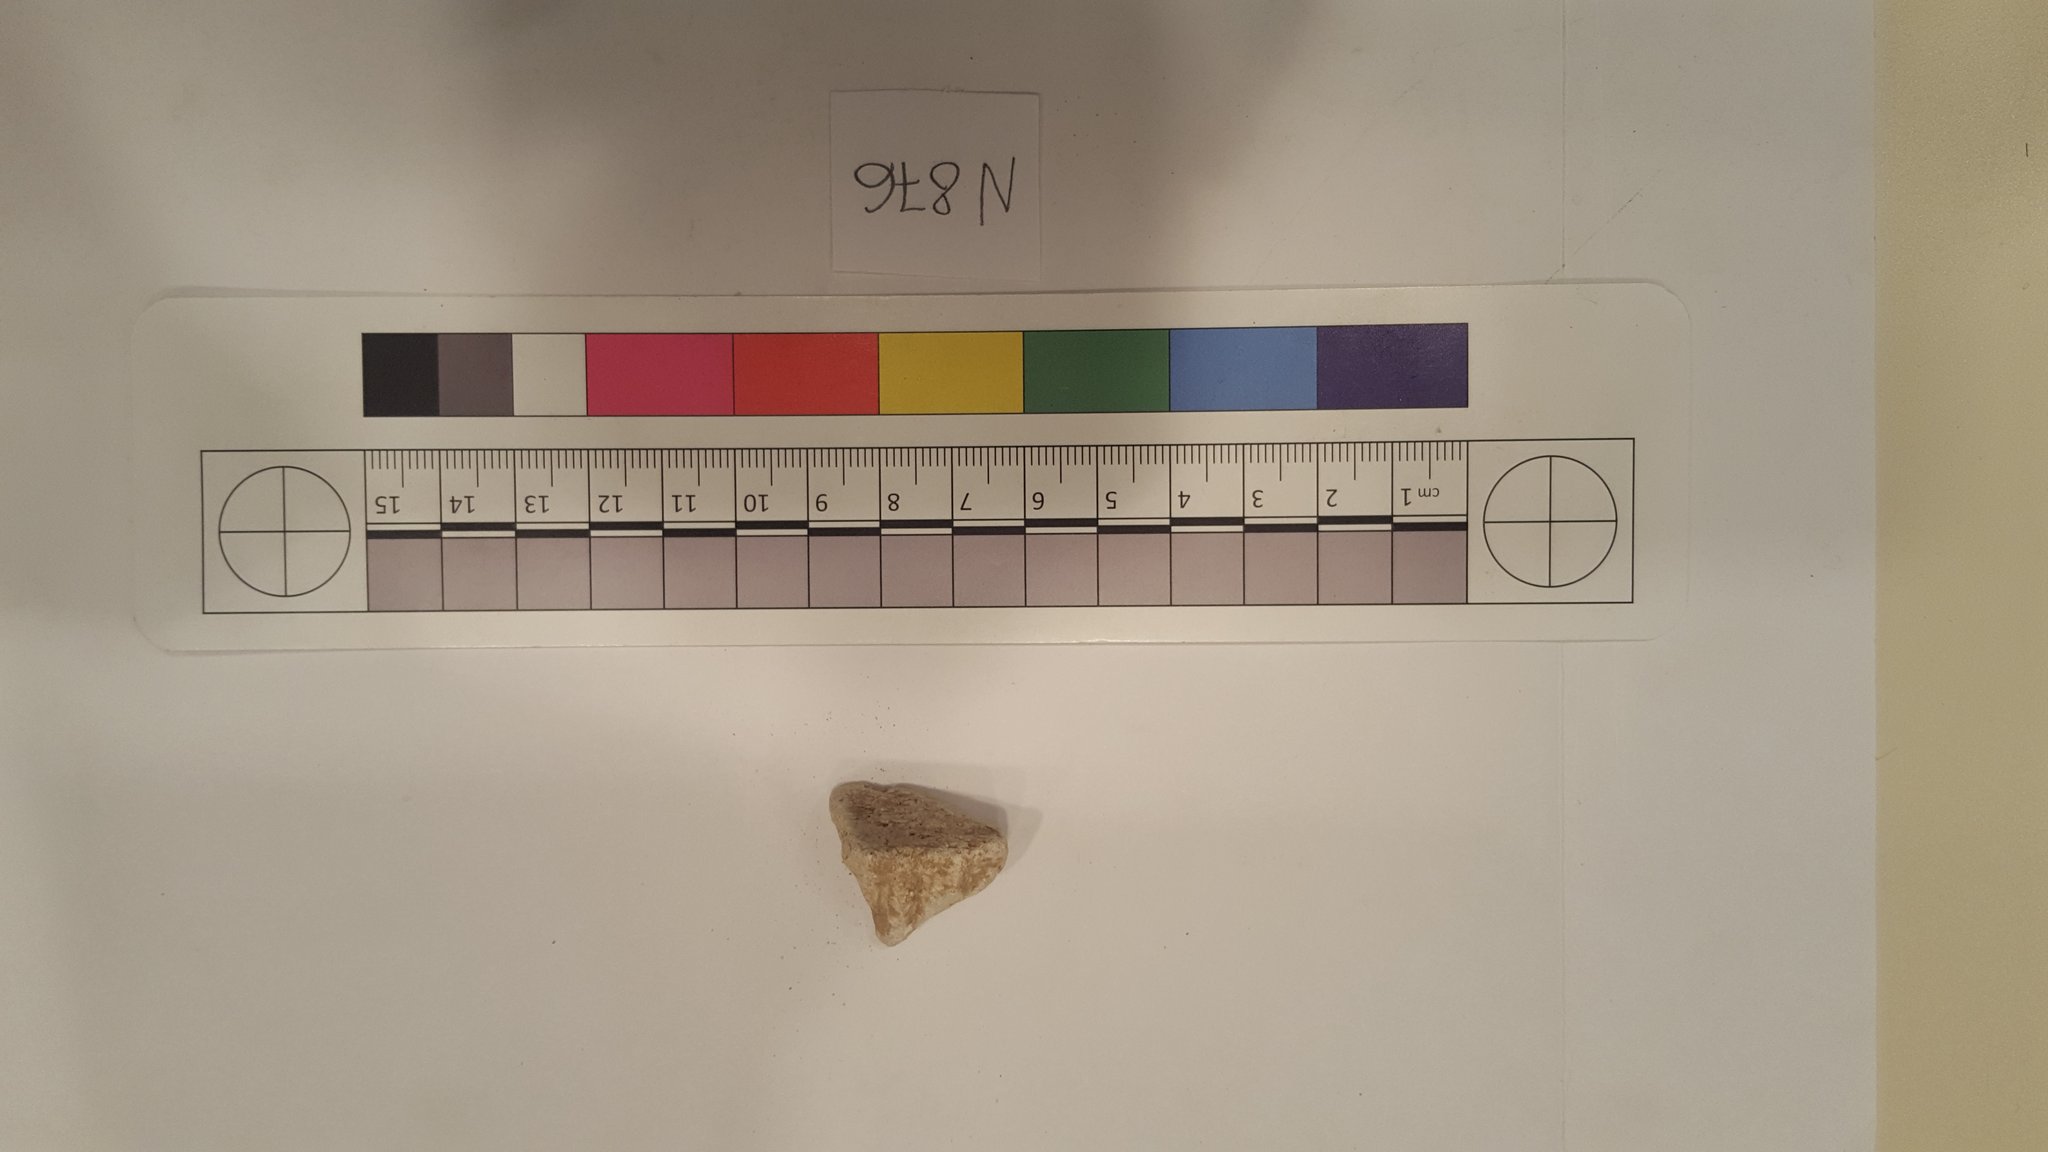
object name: fragment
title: Stucco Fragment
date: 701-1200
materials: plaster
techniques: carving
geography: iran